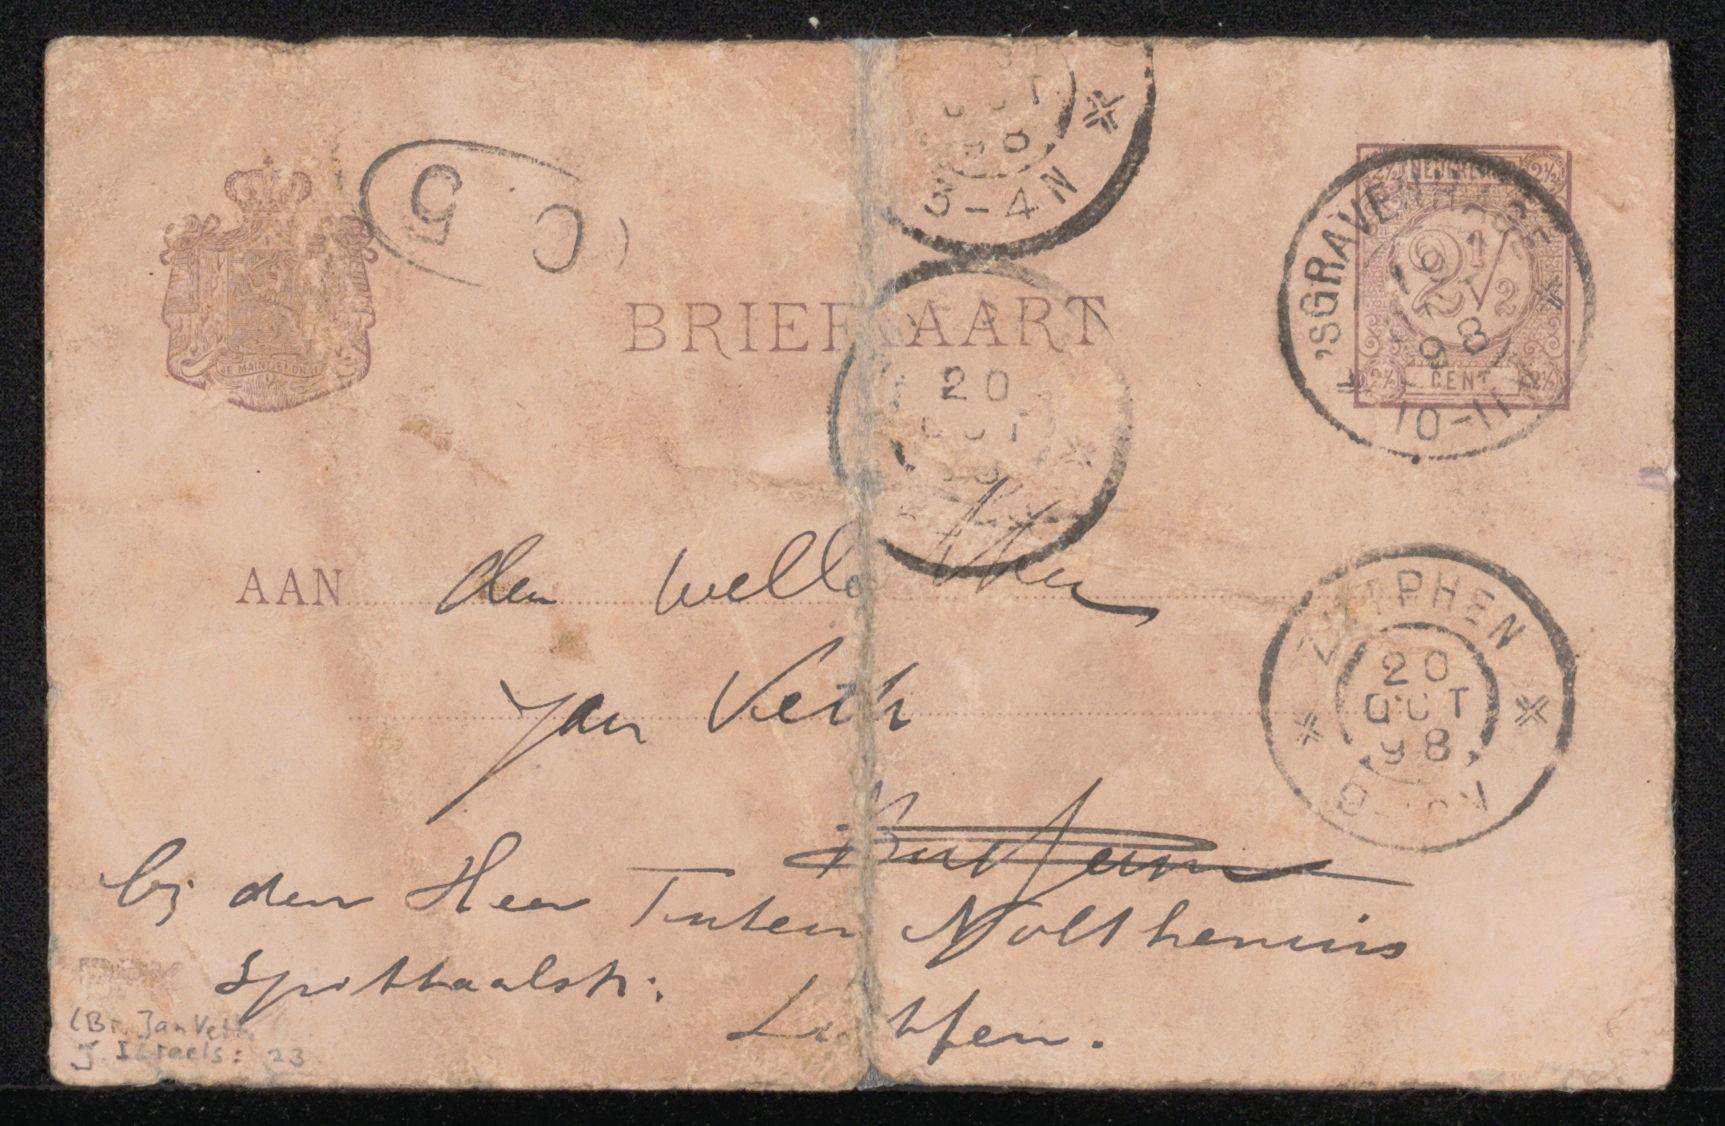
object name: postcard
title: Briefkaart aan Jan Veth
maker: jozef israëls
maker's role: draughtsman, painter, print maker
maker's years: 1824-1911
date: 1898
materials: cardboard, ink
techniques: pen, writing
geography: the hague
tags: dordrecht, amsterdam, jan veth, rembrandt van rijn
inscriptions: collector's mark: ‘RPK’